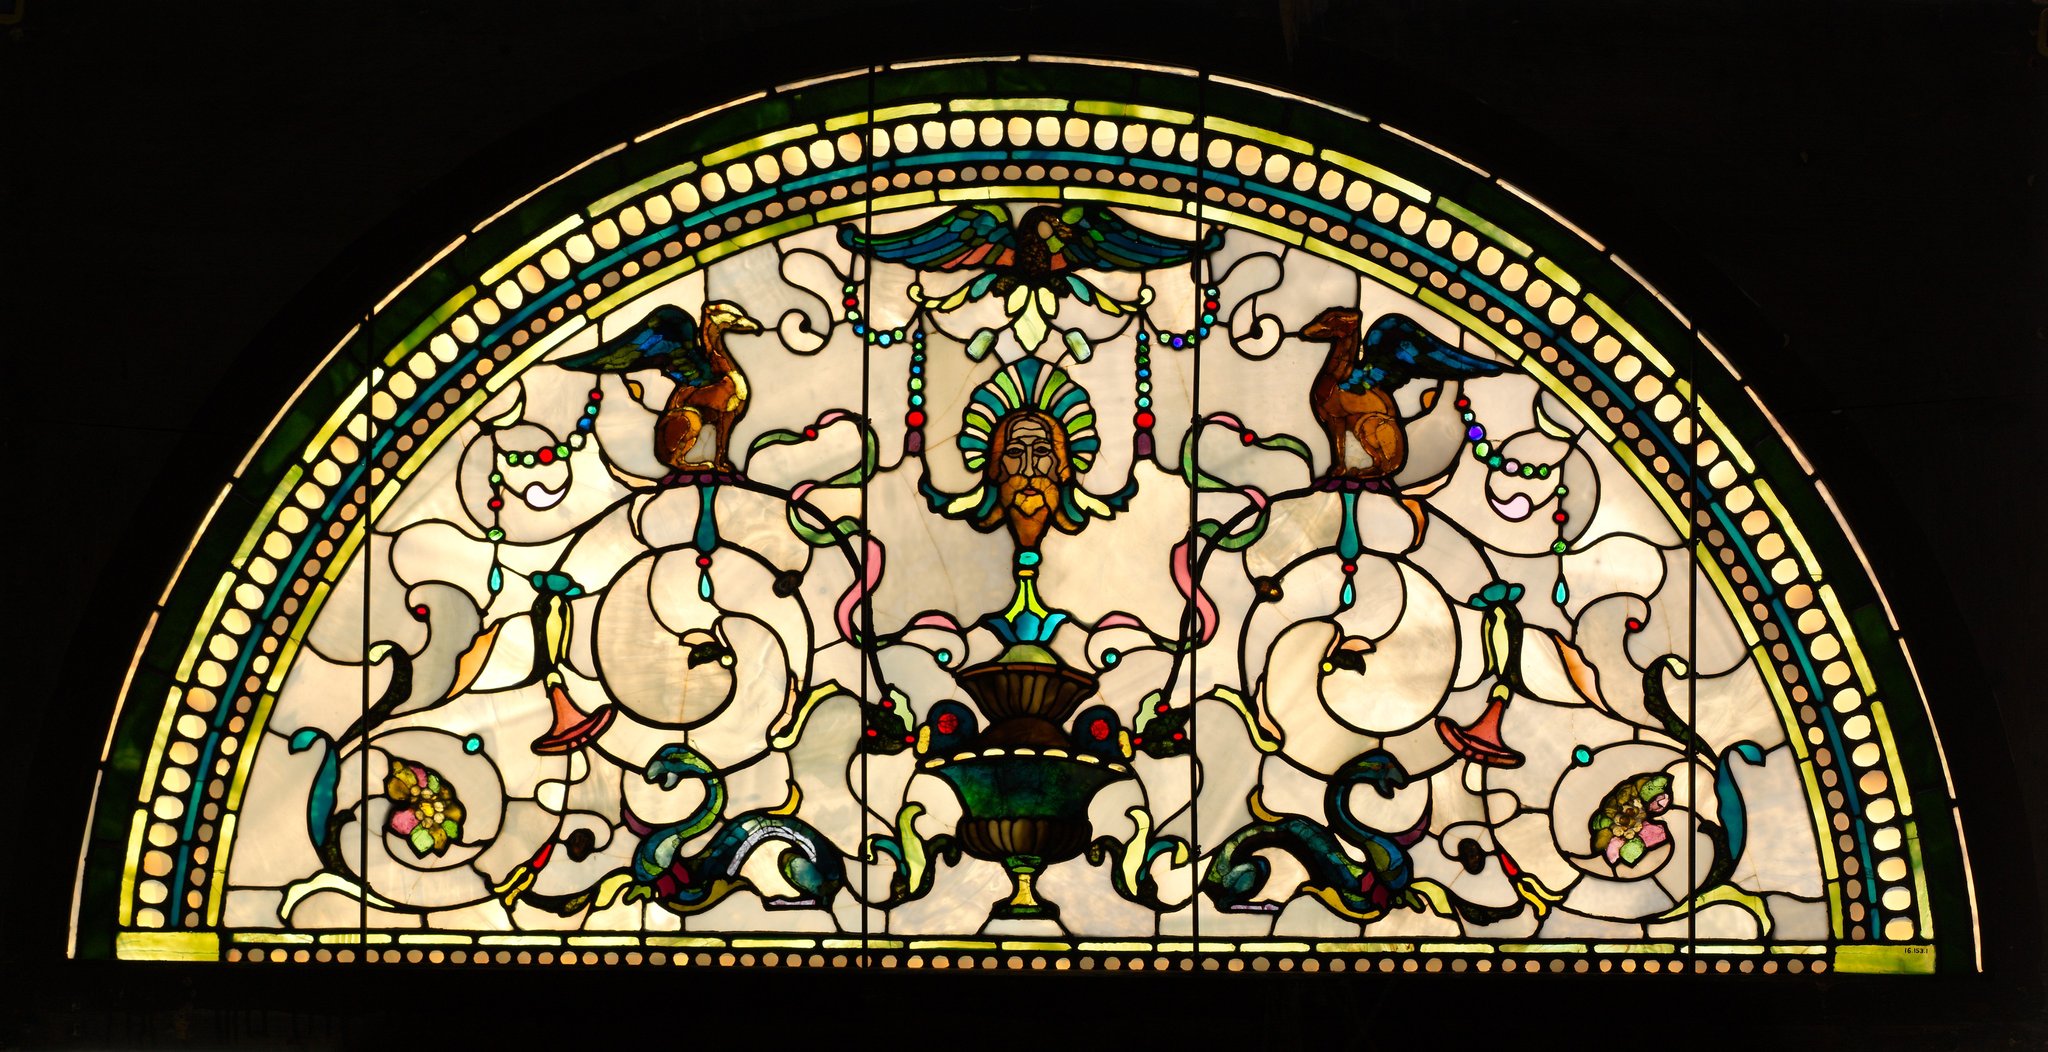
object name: lunette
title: Stained Glass Lunette from the Cornelius Vanderbilt II House, New York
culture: american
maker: john la farge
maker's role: maker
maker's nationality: american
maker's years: 1835-1910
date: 1880-1882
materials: glass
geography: united states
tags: griffins,serpents